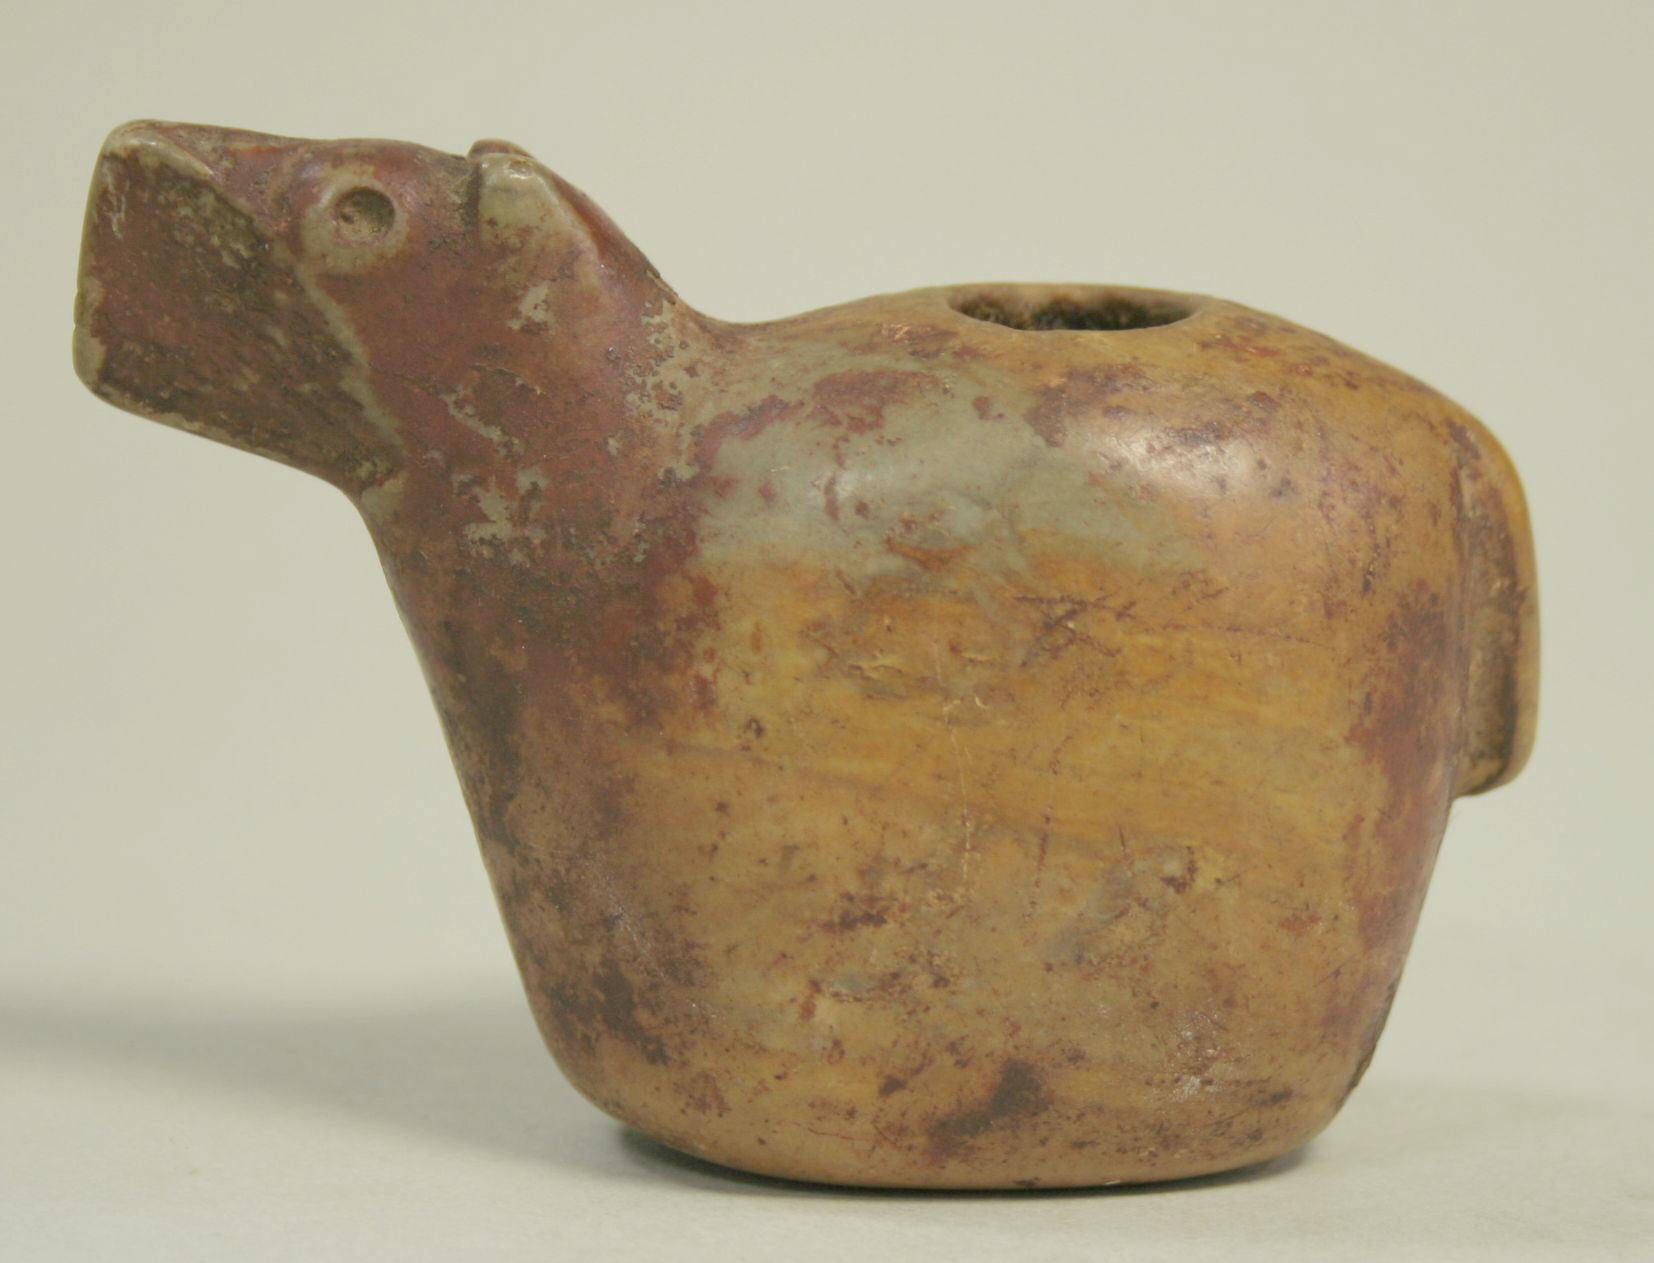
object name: container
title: Votive Container (Canopa)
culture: inca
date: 1401-1600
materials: stone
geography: bolivia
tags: animals